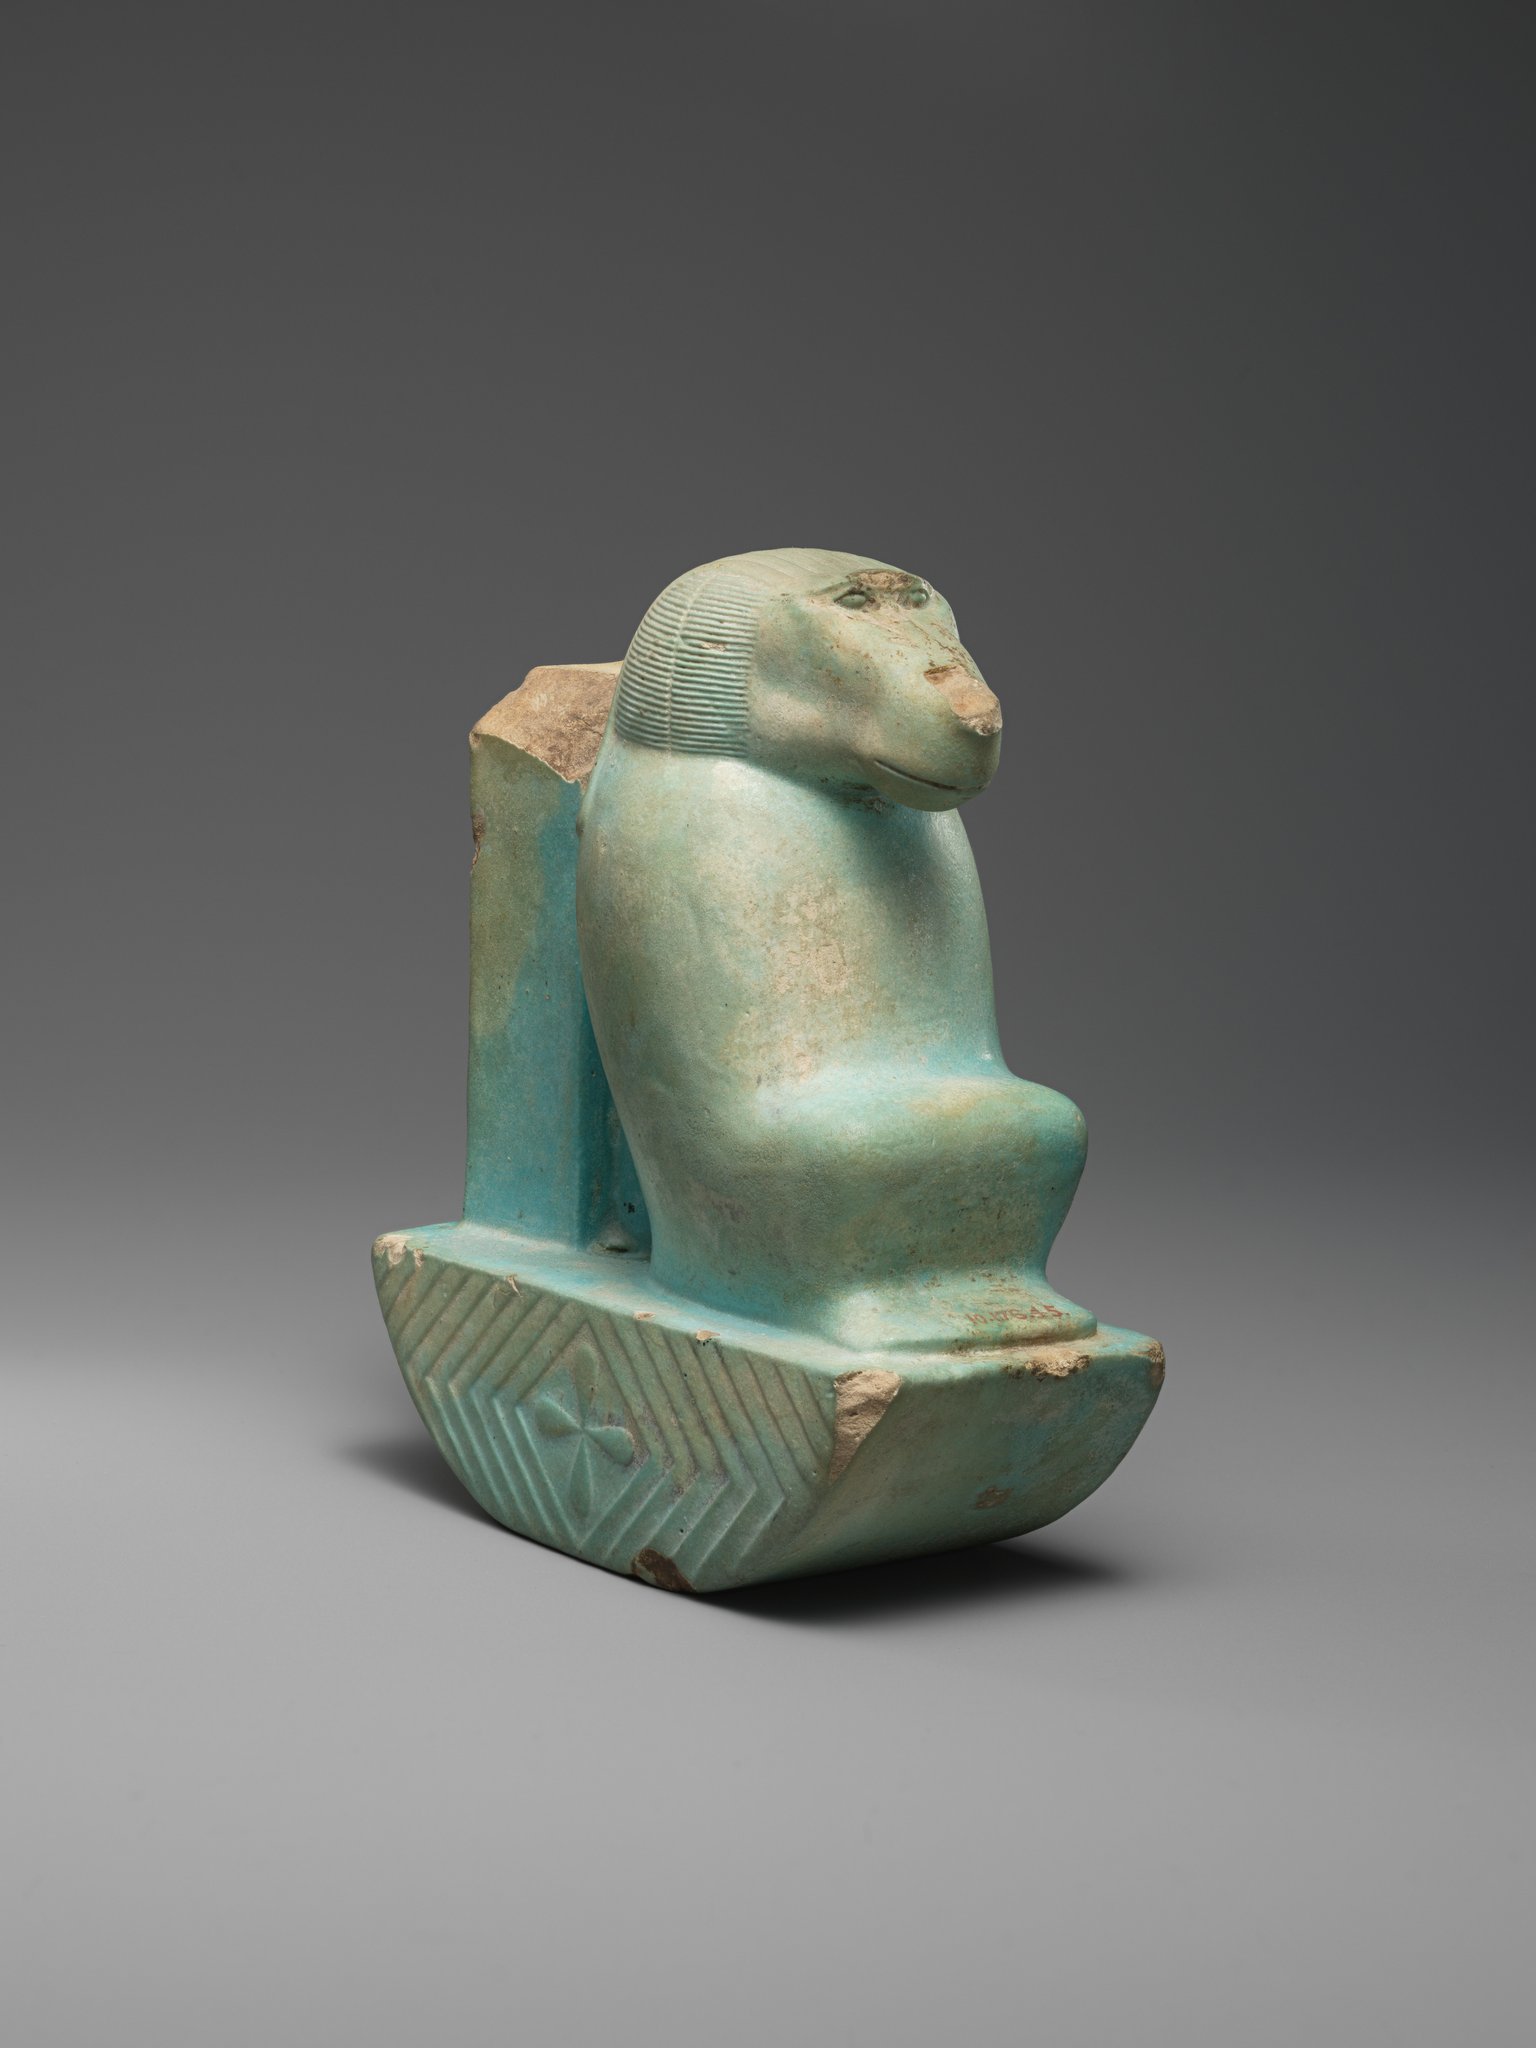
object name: amulet, baboon, basket, pillar, shebet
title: Figure of baboon on a basket and with a pillar (shebet offering)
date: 664-332 BCE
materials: faience, glaze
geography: memphite region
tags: baboons